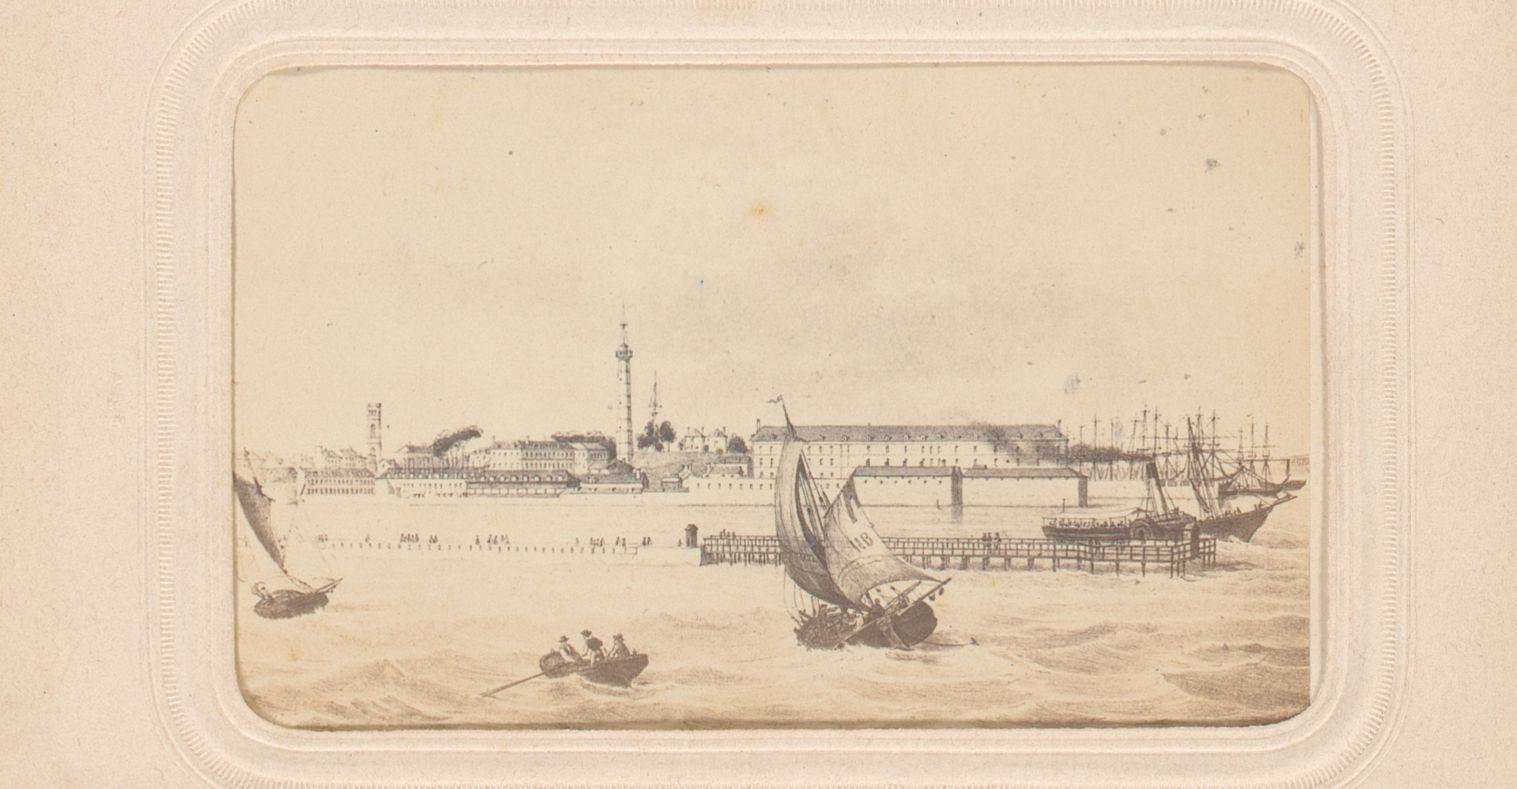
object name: reproduction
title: Fotoreproductie van een zeegezicht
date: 1859-1867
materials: cardboard, photographic support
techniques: albumen print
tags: sea (seascape)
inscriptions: inscription: ‘F. Sinnett, Editeur/ 17, Rue d'Argenteuil/ Colliau, Photographe/Paris.’